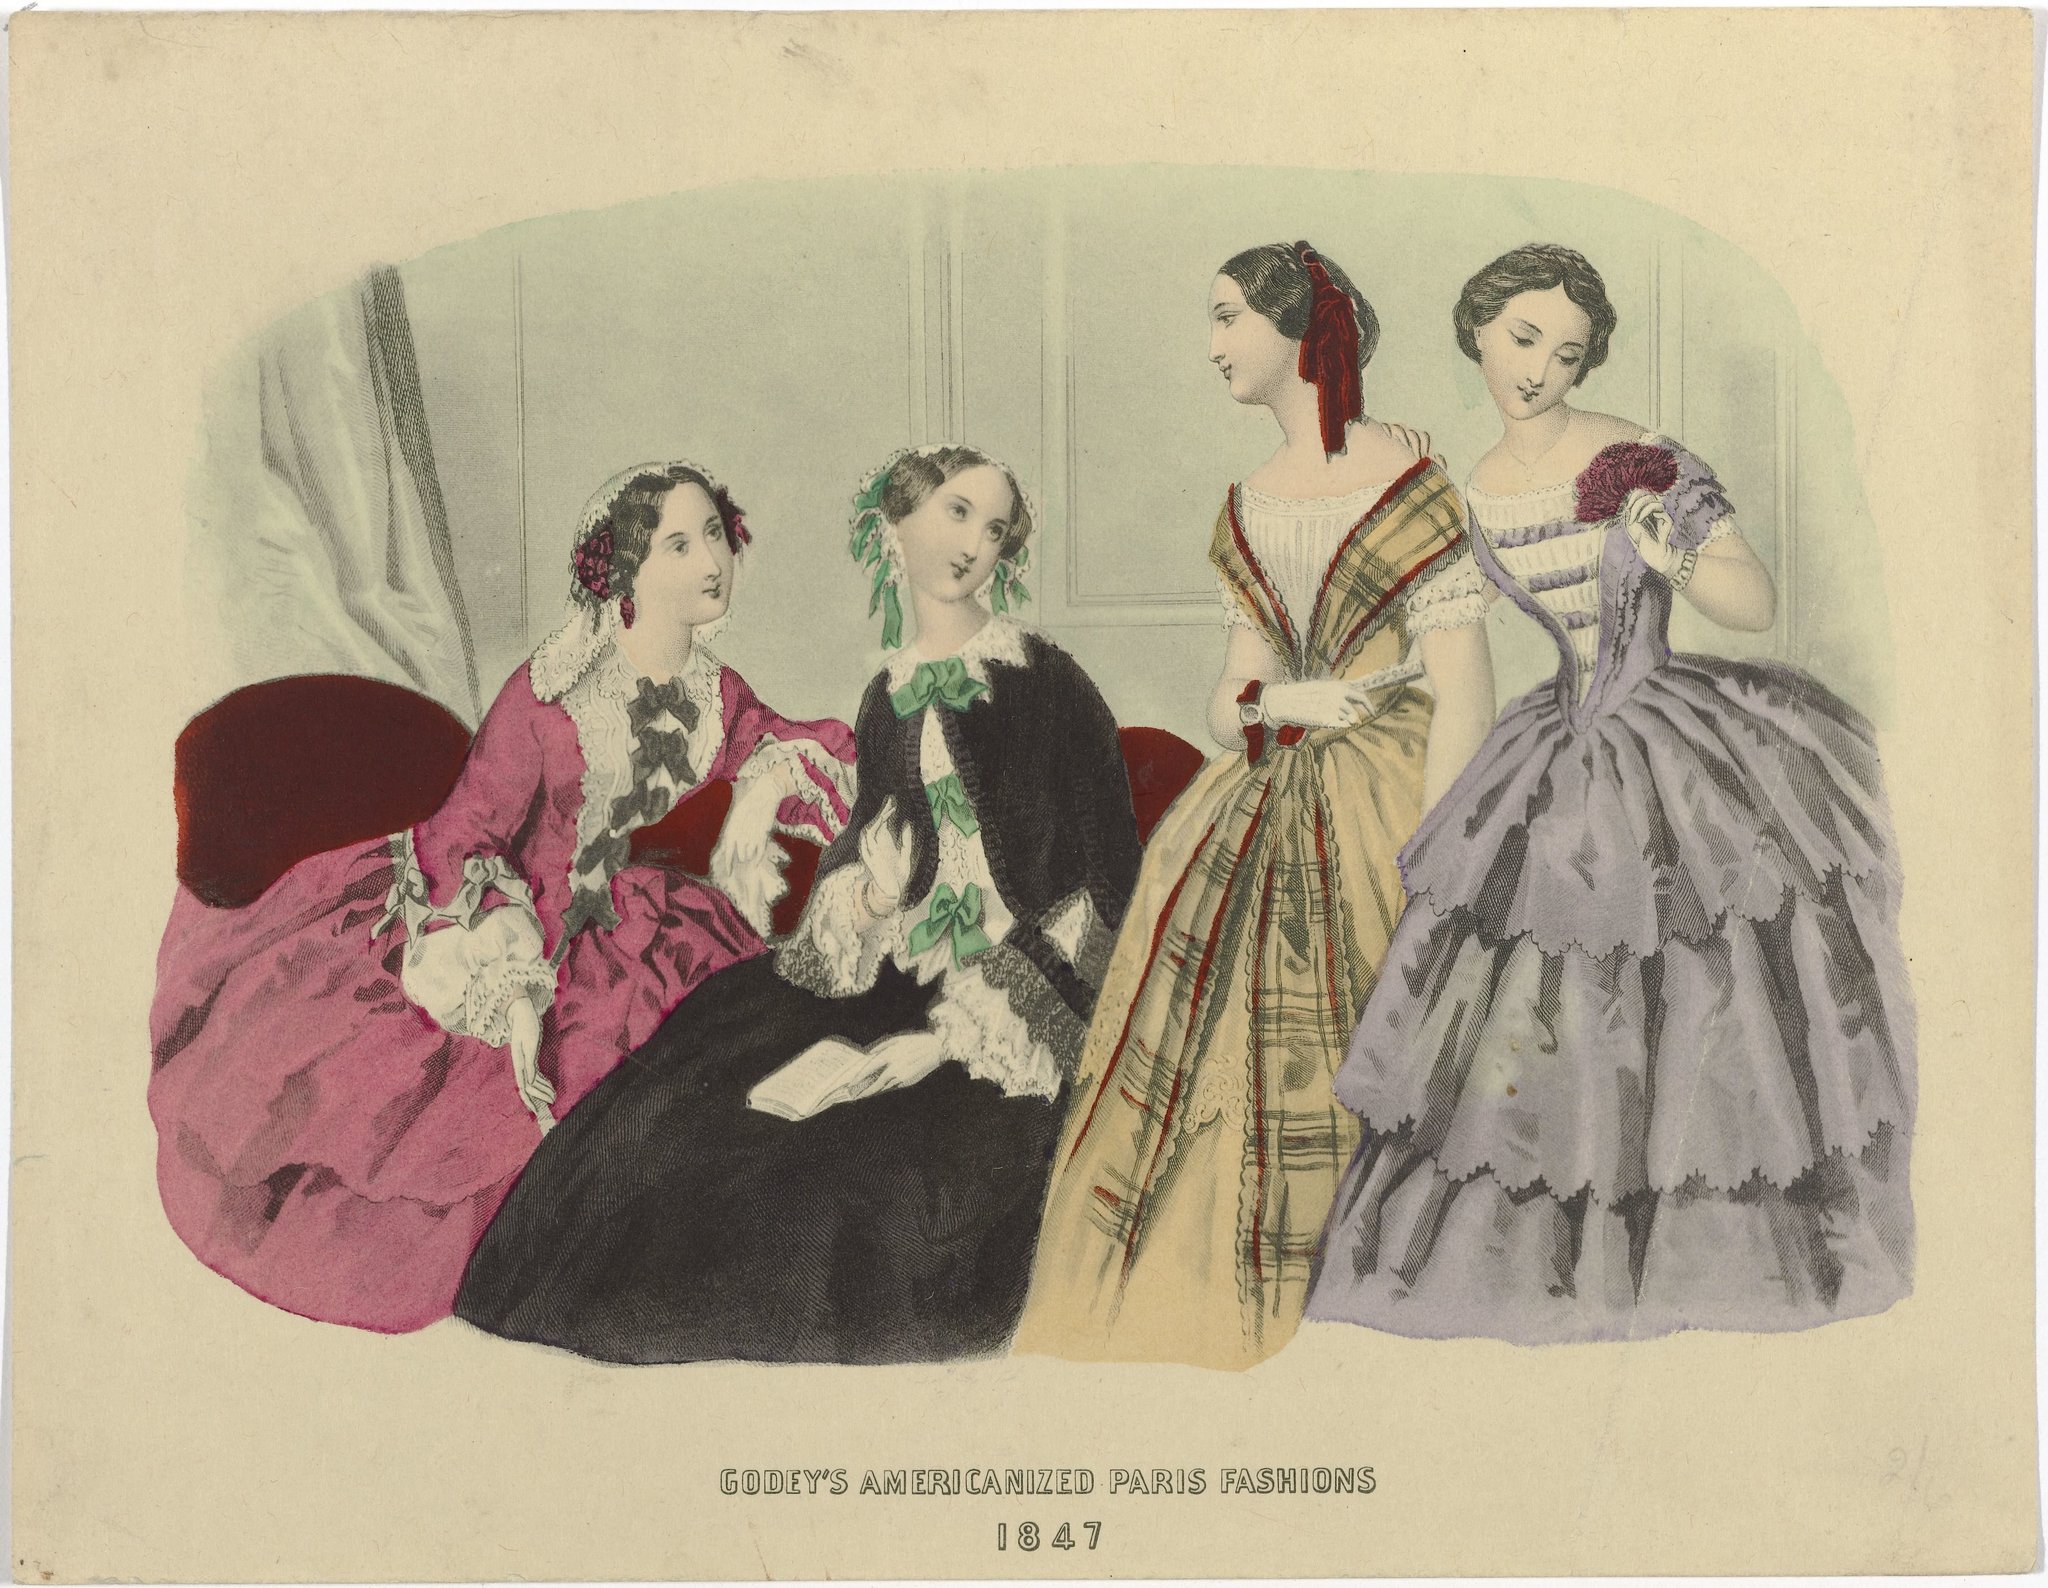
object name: fashion print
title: Godey's Ladies Book 1847 : Godey's Americanized Paris Fashions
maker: Anonymous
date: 1847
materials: paper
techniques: engraving, hand coloring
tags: fashion plates, dress, gown (+ women's clothes)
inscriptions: date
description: Amerikaanse vrouwenmode 1847. Prent uit het modetijdschrift Godey's Ladies Book (Philadelphia, Amerika, 1830-1898.